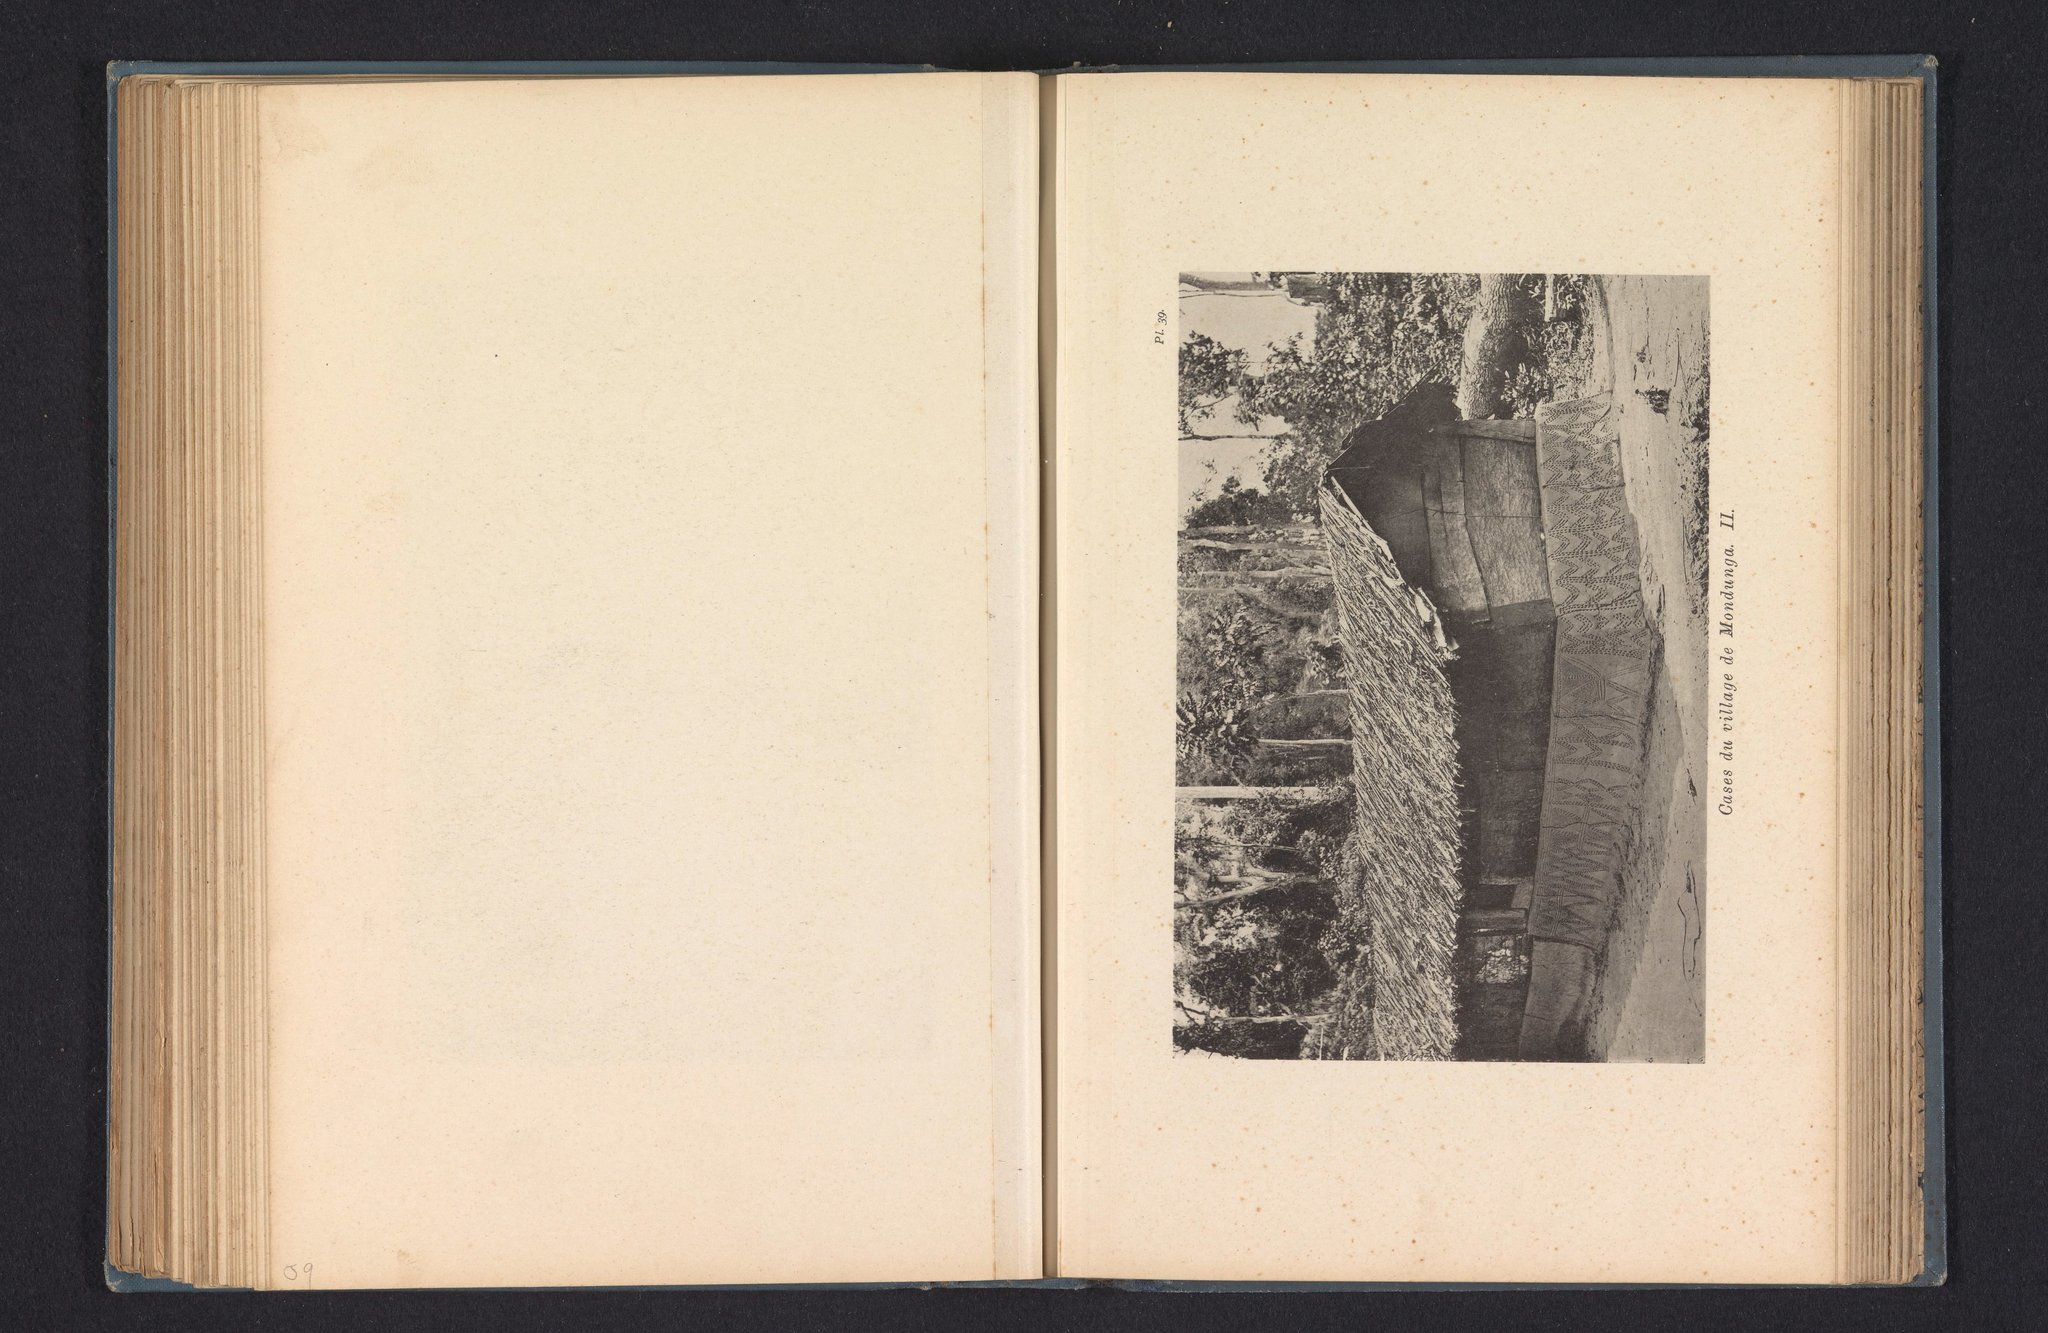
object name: page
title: Cases du village de Mondunga II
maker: franz thonner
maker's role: botanicus, ontdekkingsreiziger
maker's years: 1863-1928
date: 1896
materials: paper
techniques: photograph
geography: congo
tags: housing, façade (of house or building)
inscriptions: number: ‘Pl. 39.’